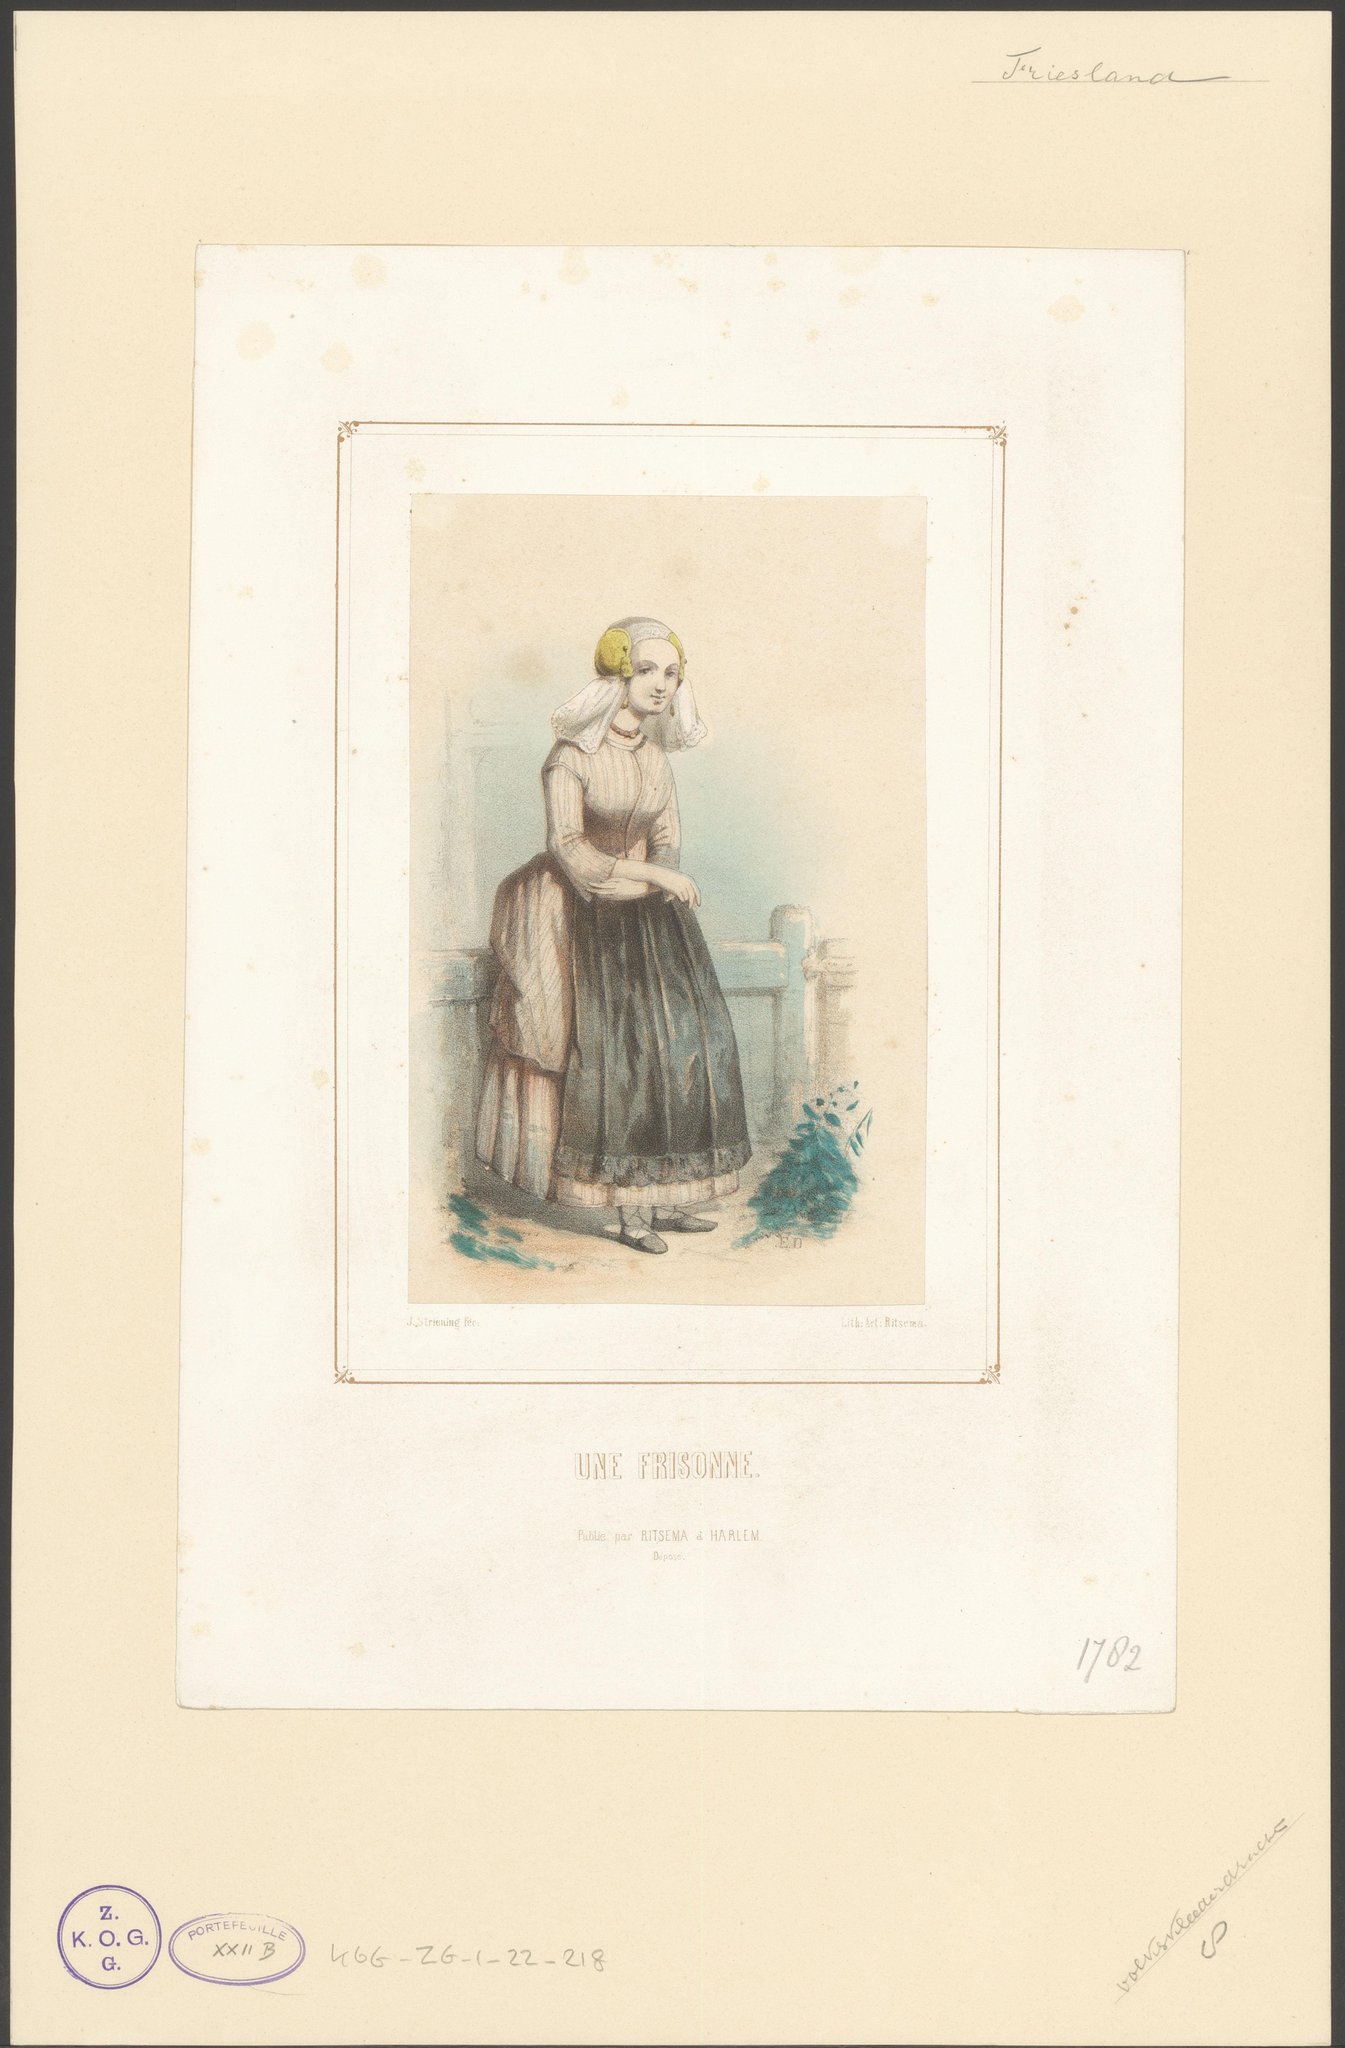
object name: print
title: Une Frisonne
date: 1858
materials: watercolor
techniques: hand coloring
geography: netherlands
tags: clothes, costume (+ women's clothes), folk costume, regional costume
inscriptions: collector's mark, collector's mark: Lugt 1641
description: Jonge vrouw van Friesland, staande bij een hek. Onderwerpsrubrieken binnen de Atlas Zeden en Gewoonten: De Kleeding, Volkskleederdracht, Friesland.